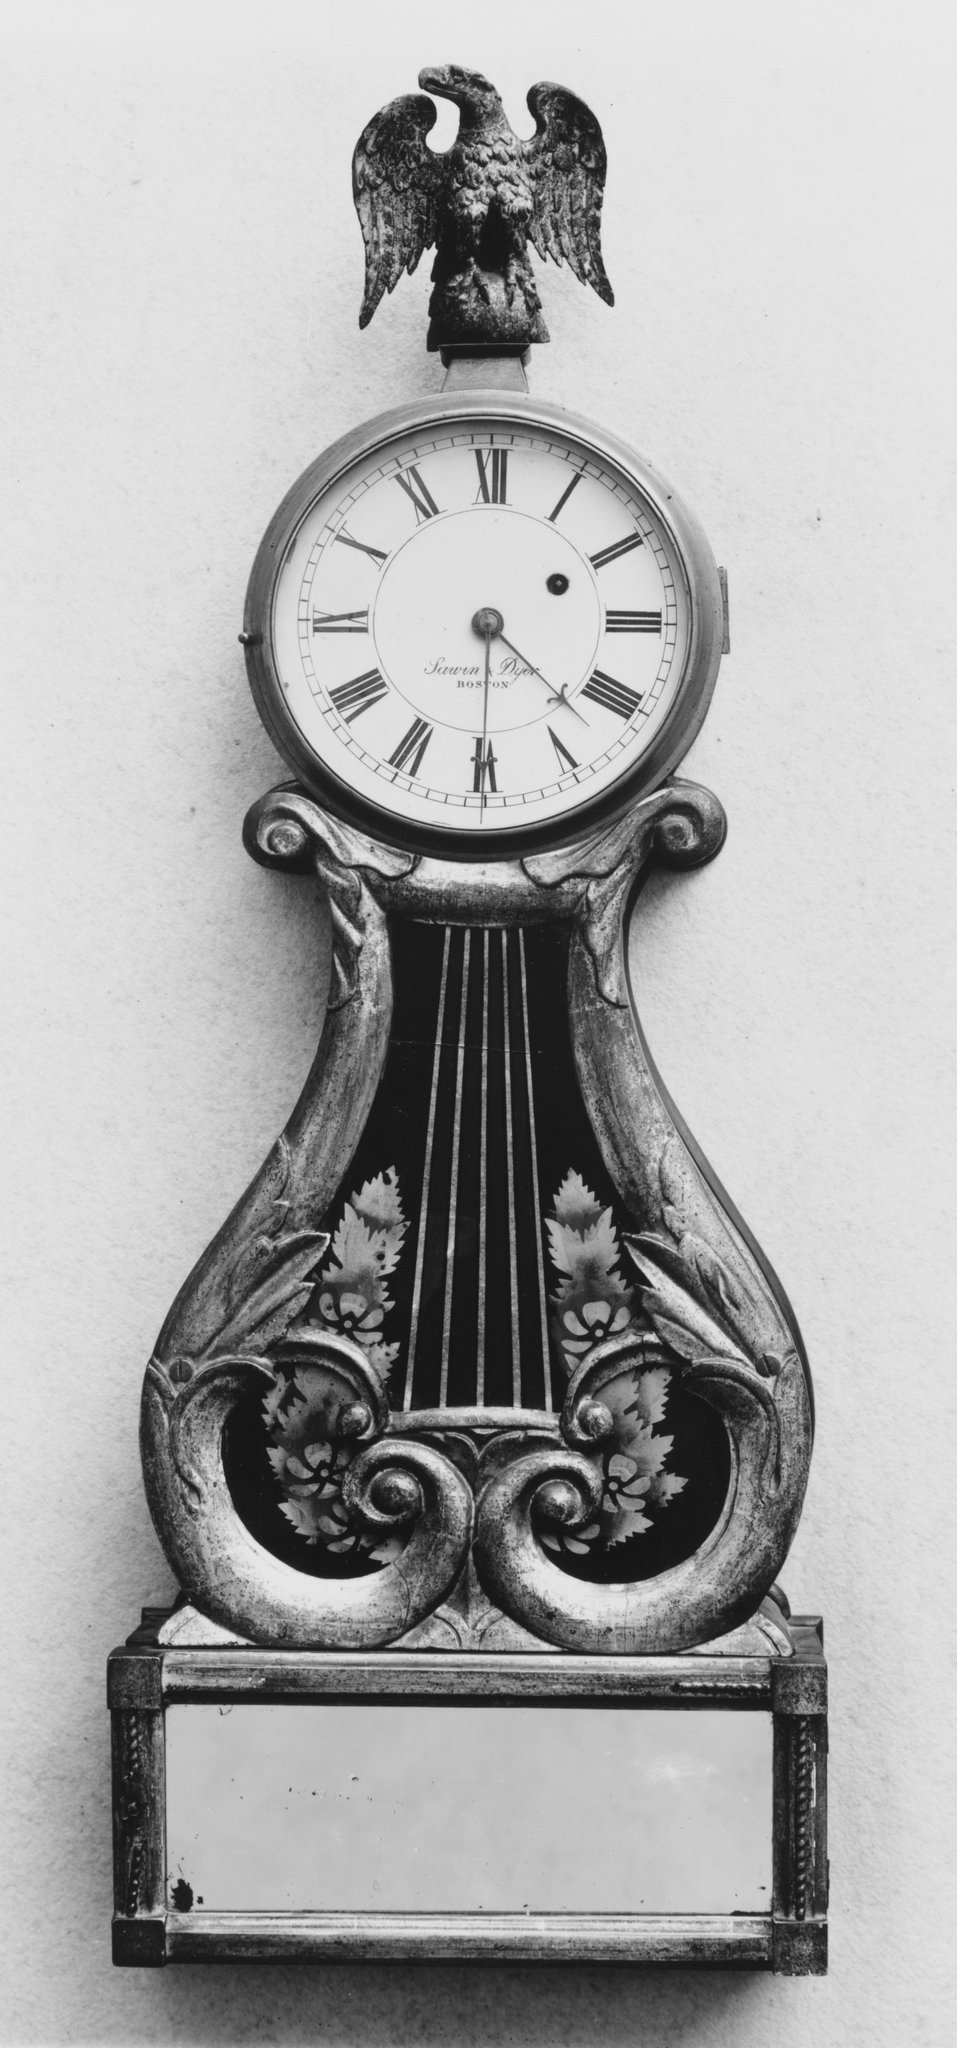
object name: lyre clock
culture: american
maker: john sawin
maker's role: maker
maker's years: 1801-1863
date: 1822-1828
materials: gesso, gilt, wood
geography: united states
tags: eagles,lyres